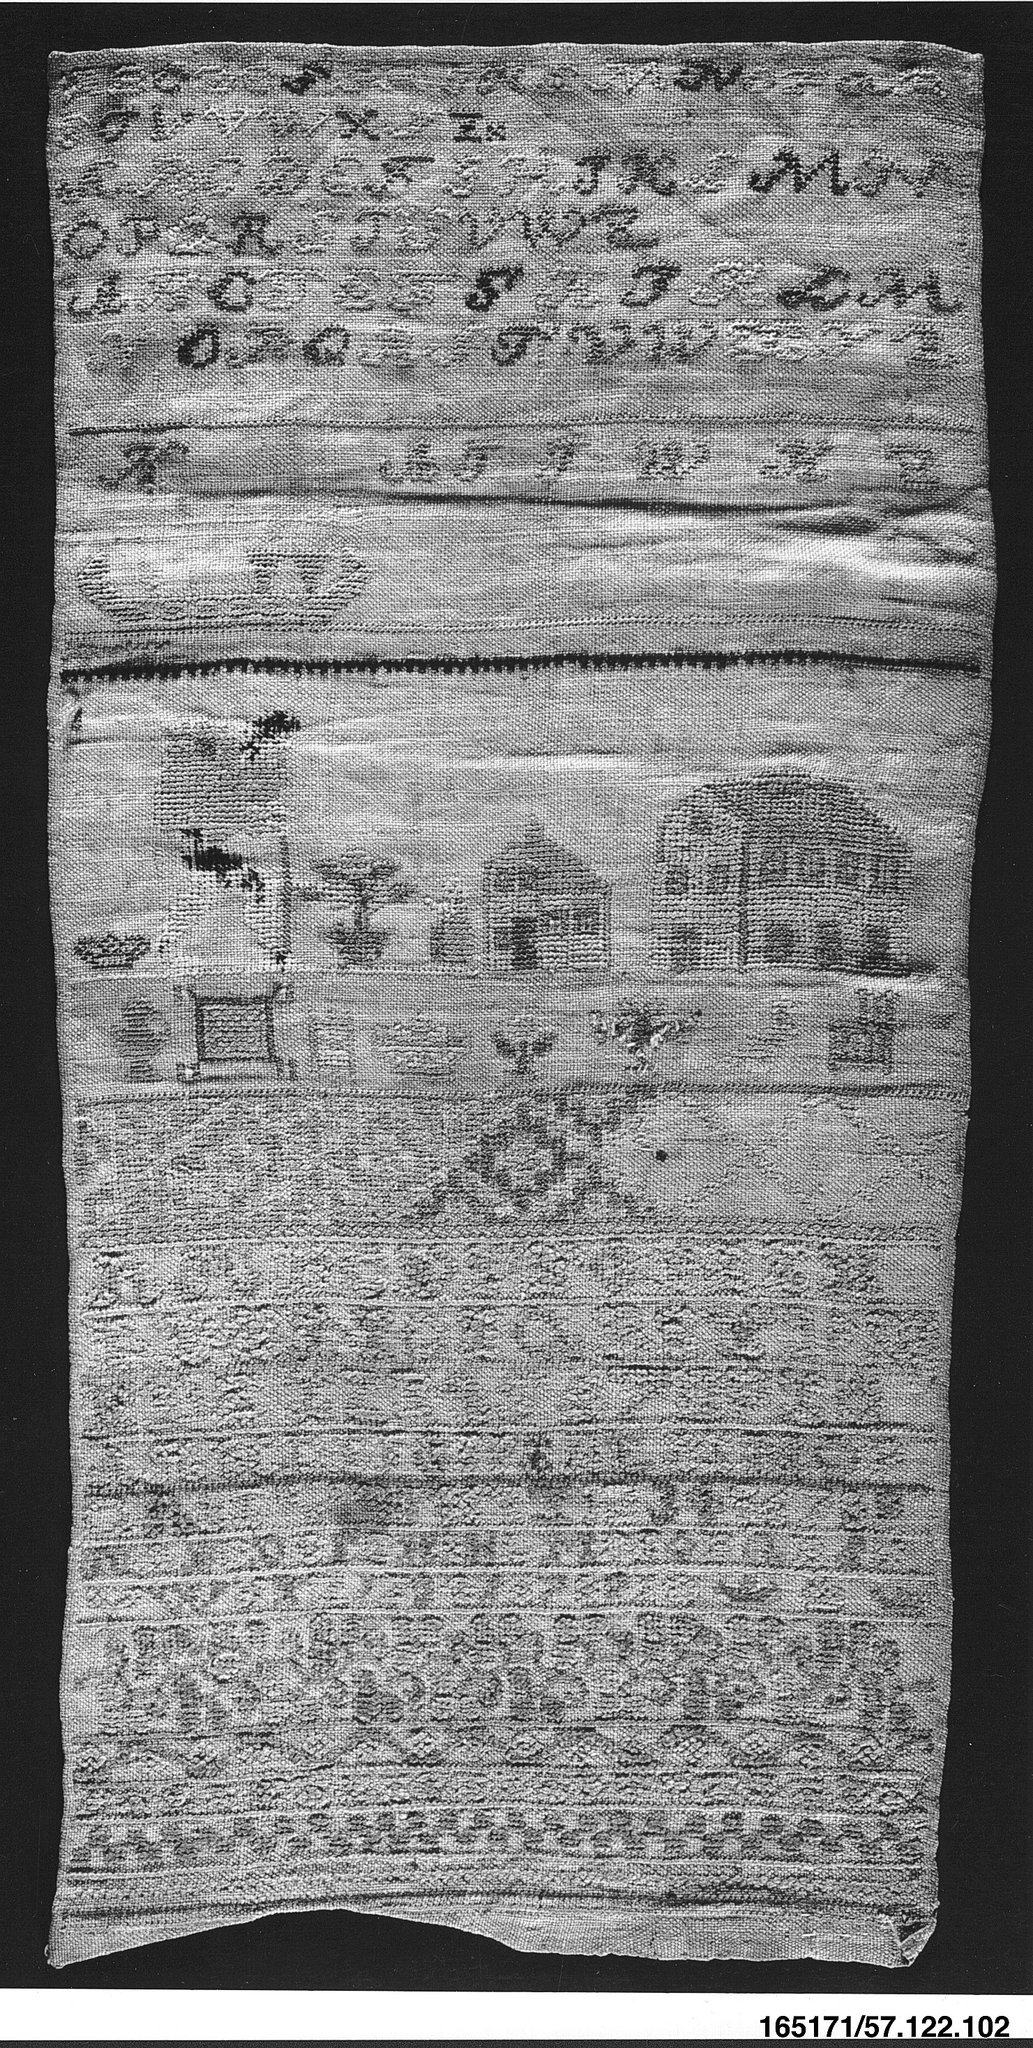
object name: sampler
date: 1701-1800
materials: linen, silk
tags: houses